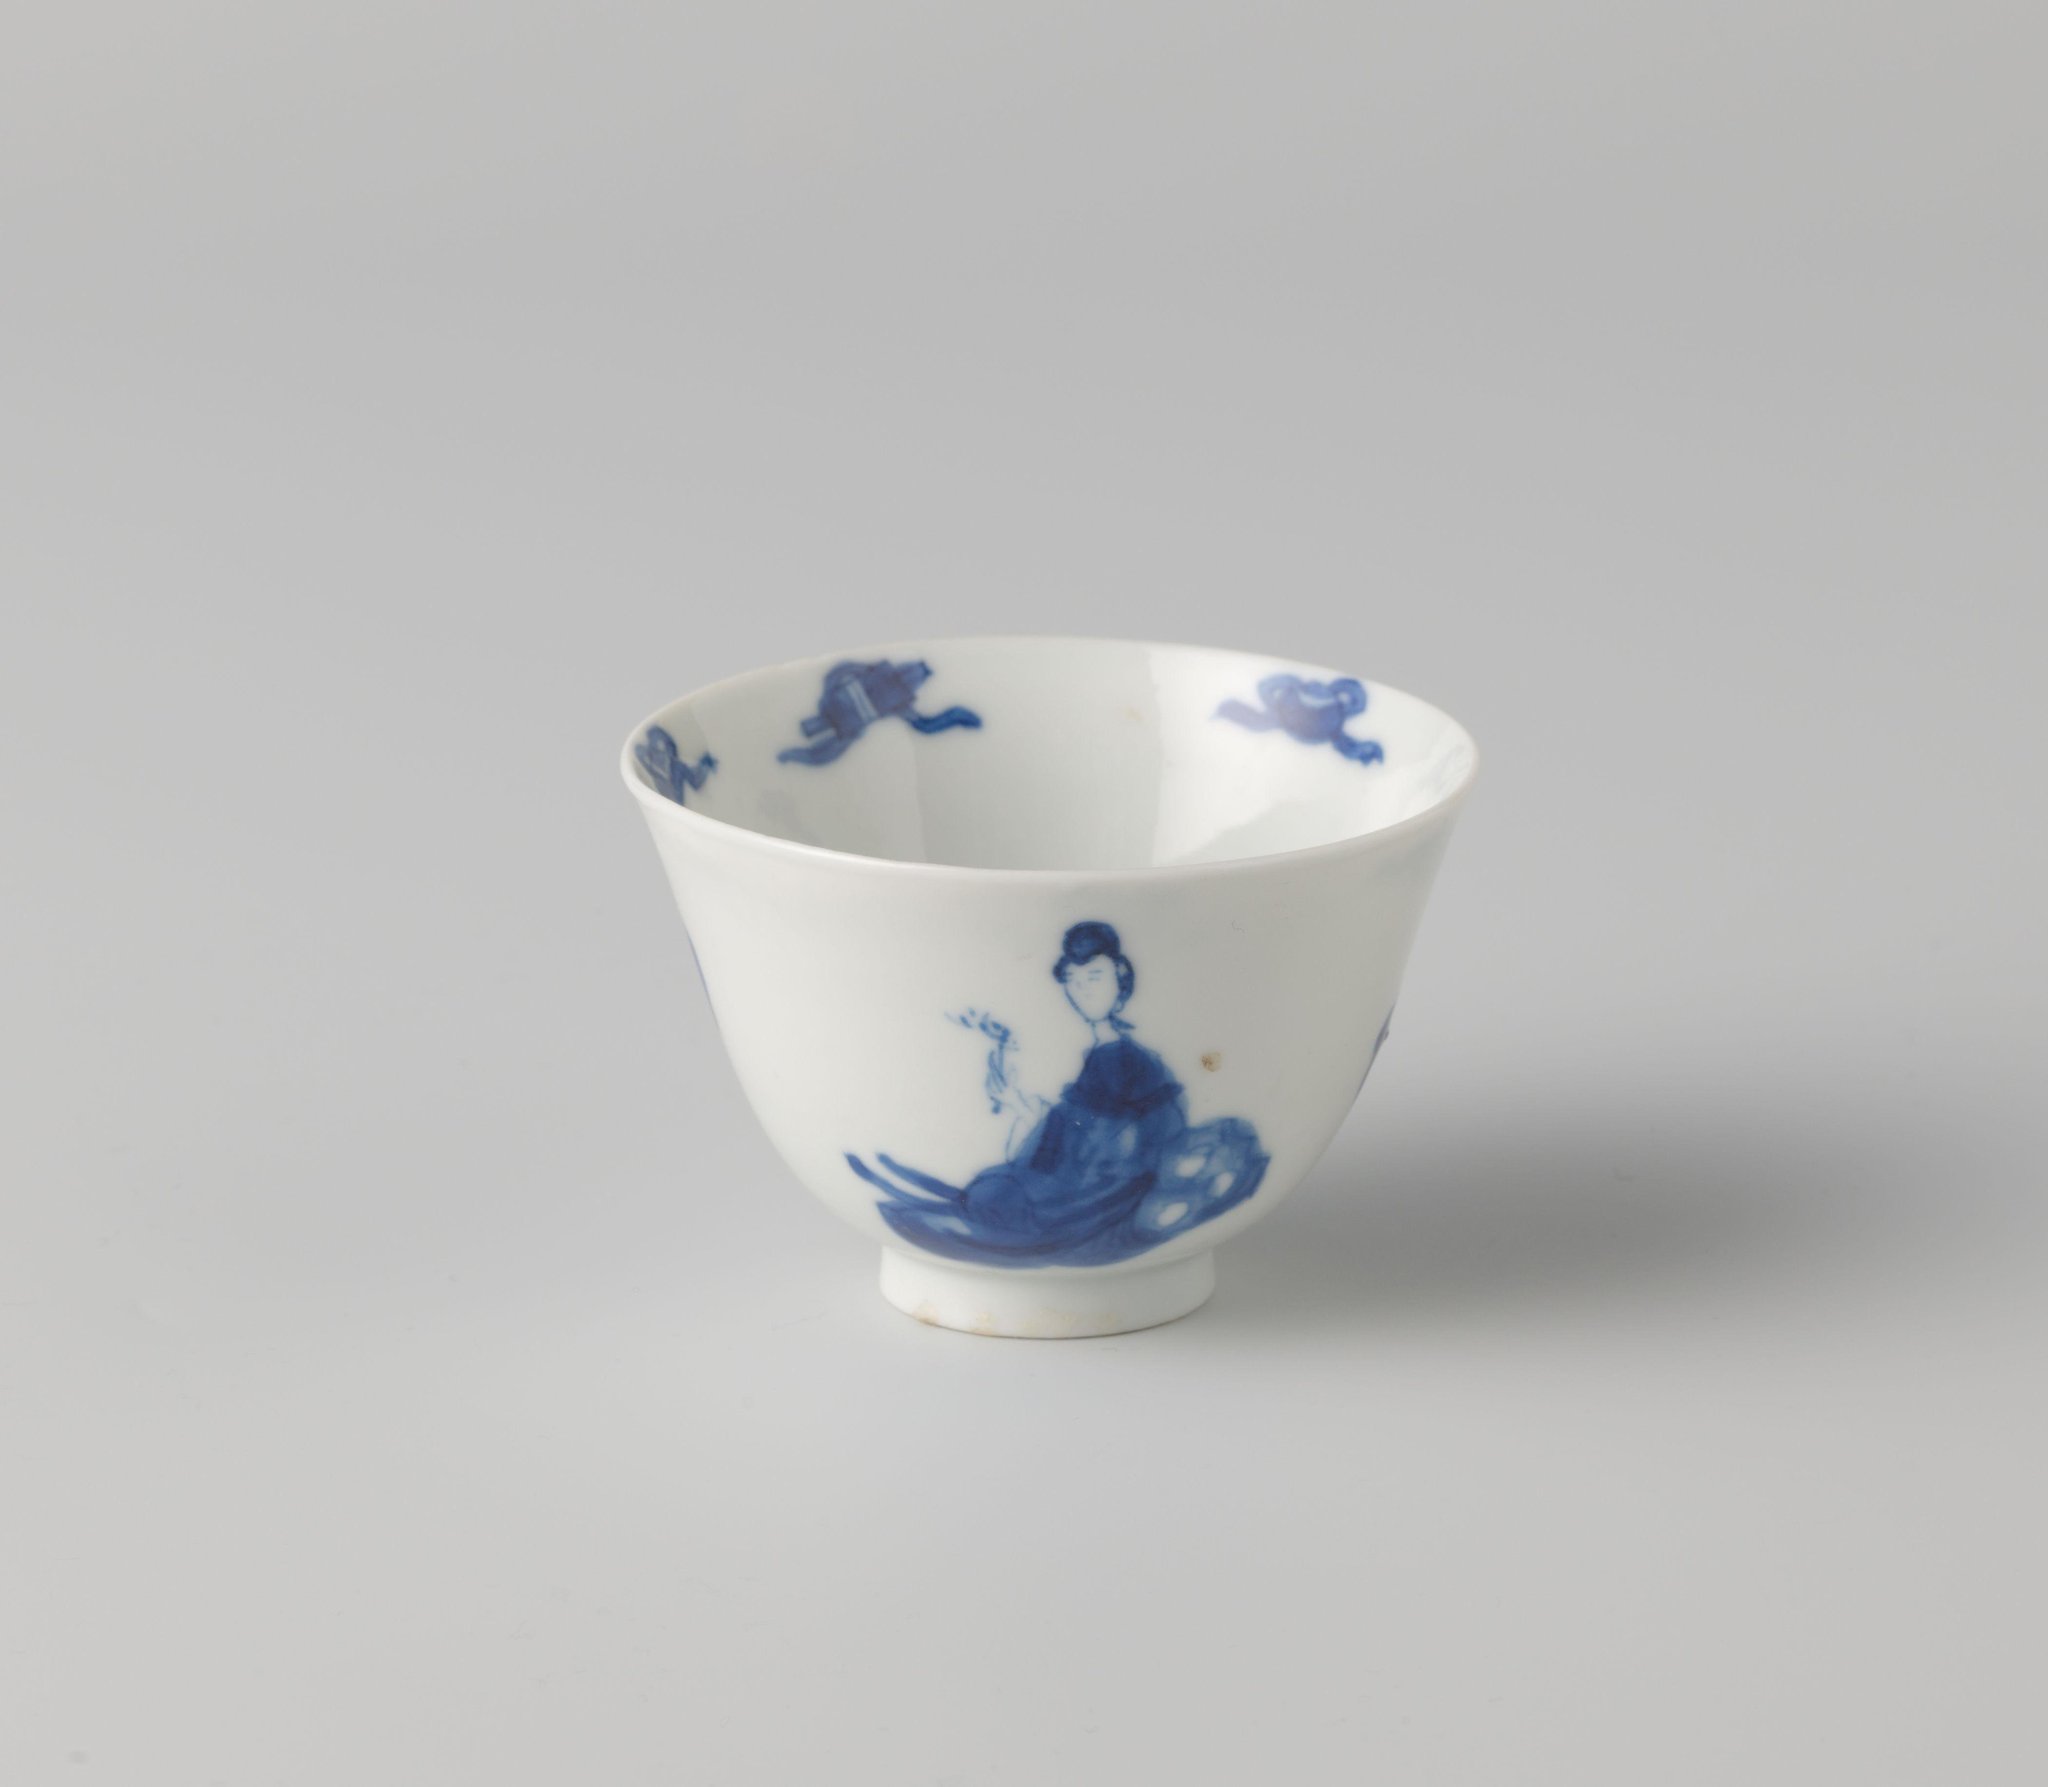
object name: kop en schotel, kop en schotel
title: Cup with a woman and boy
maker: Anonymous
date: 1680-1720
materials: cobalt, glaze, paint, porcelain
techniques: firing, turning, vitrification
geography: china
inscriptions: mark: ‘成 化 年 製’, mark: ‘大 明 宣 德 年 製’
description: Schotel, twee Chinezen in een landschap. Klokvormige kop met lijs.